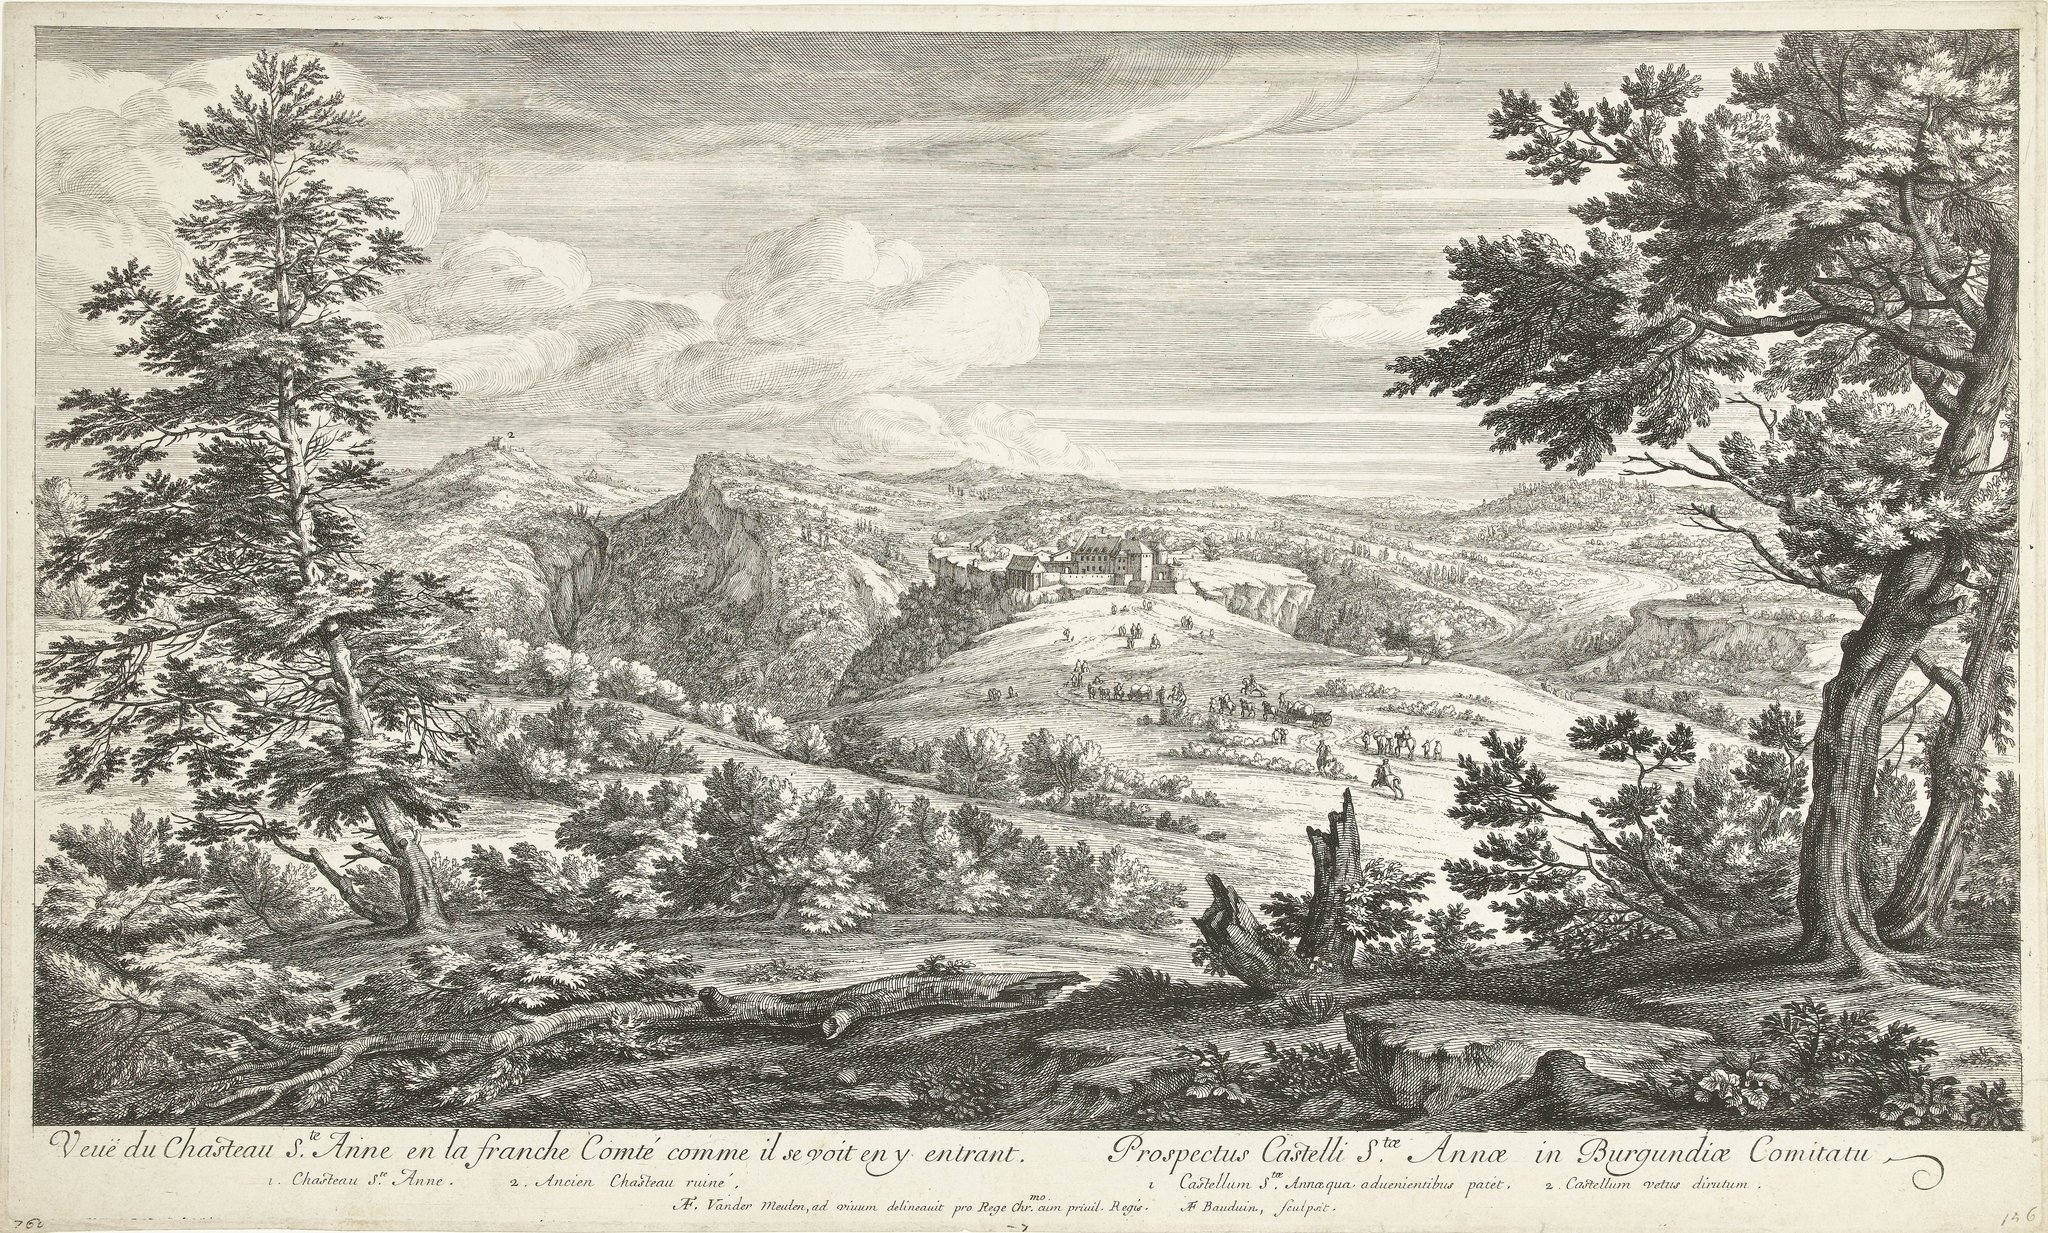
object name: print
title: Veuë du chasteau Ste. Anne en la franche Comté comme il se voit en y entrant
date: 1666-1681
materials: paper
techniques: engraving, etching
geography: paris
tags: castle, landscapes in the temperate zone, ruin of a dwelling, house, castle, etc.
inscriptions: collector's mark: Lugt 240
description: Gezicht op het kasteel Sainte Anne en de ruïne van het oude kasteel met de landerijen eromheen.